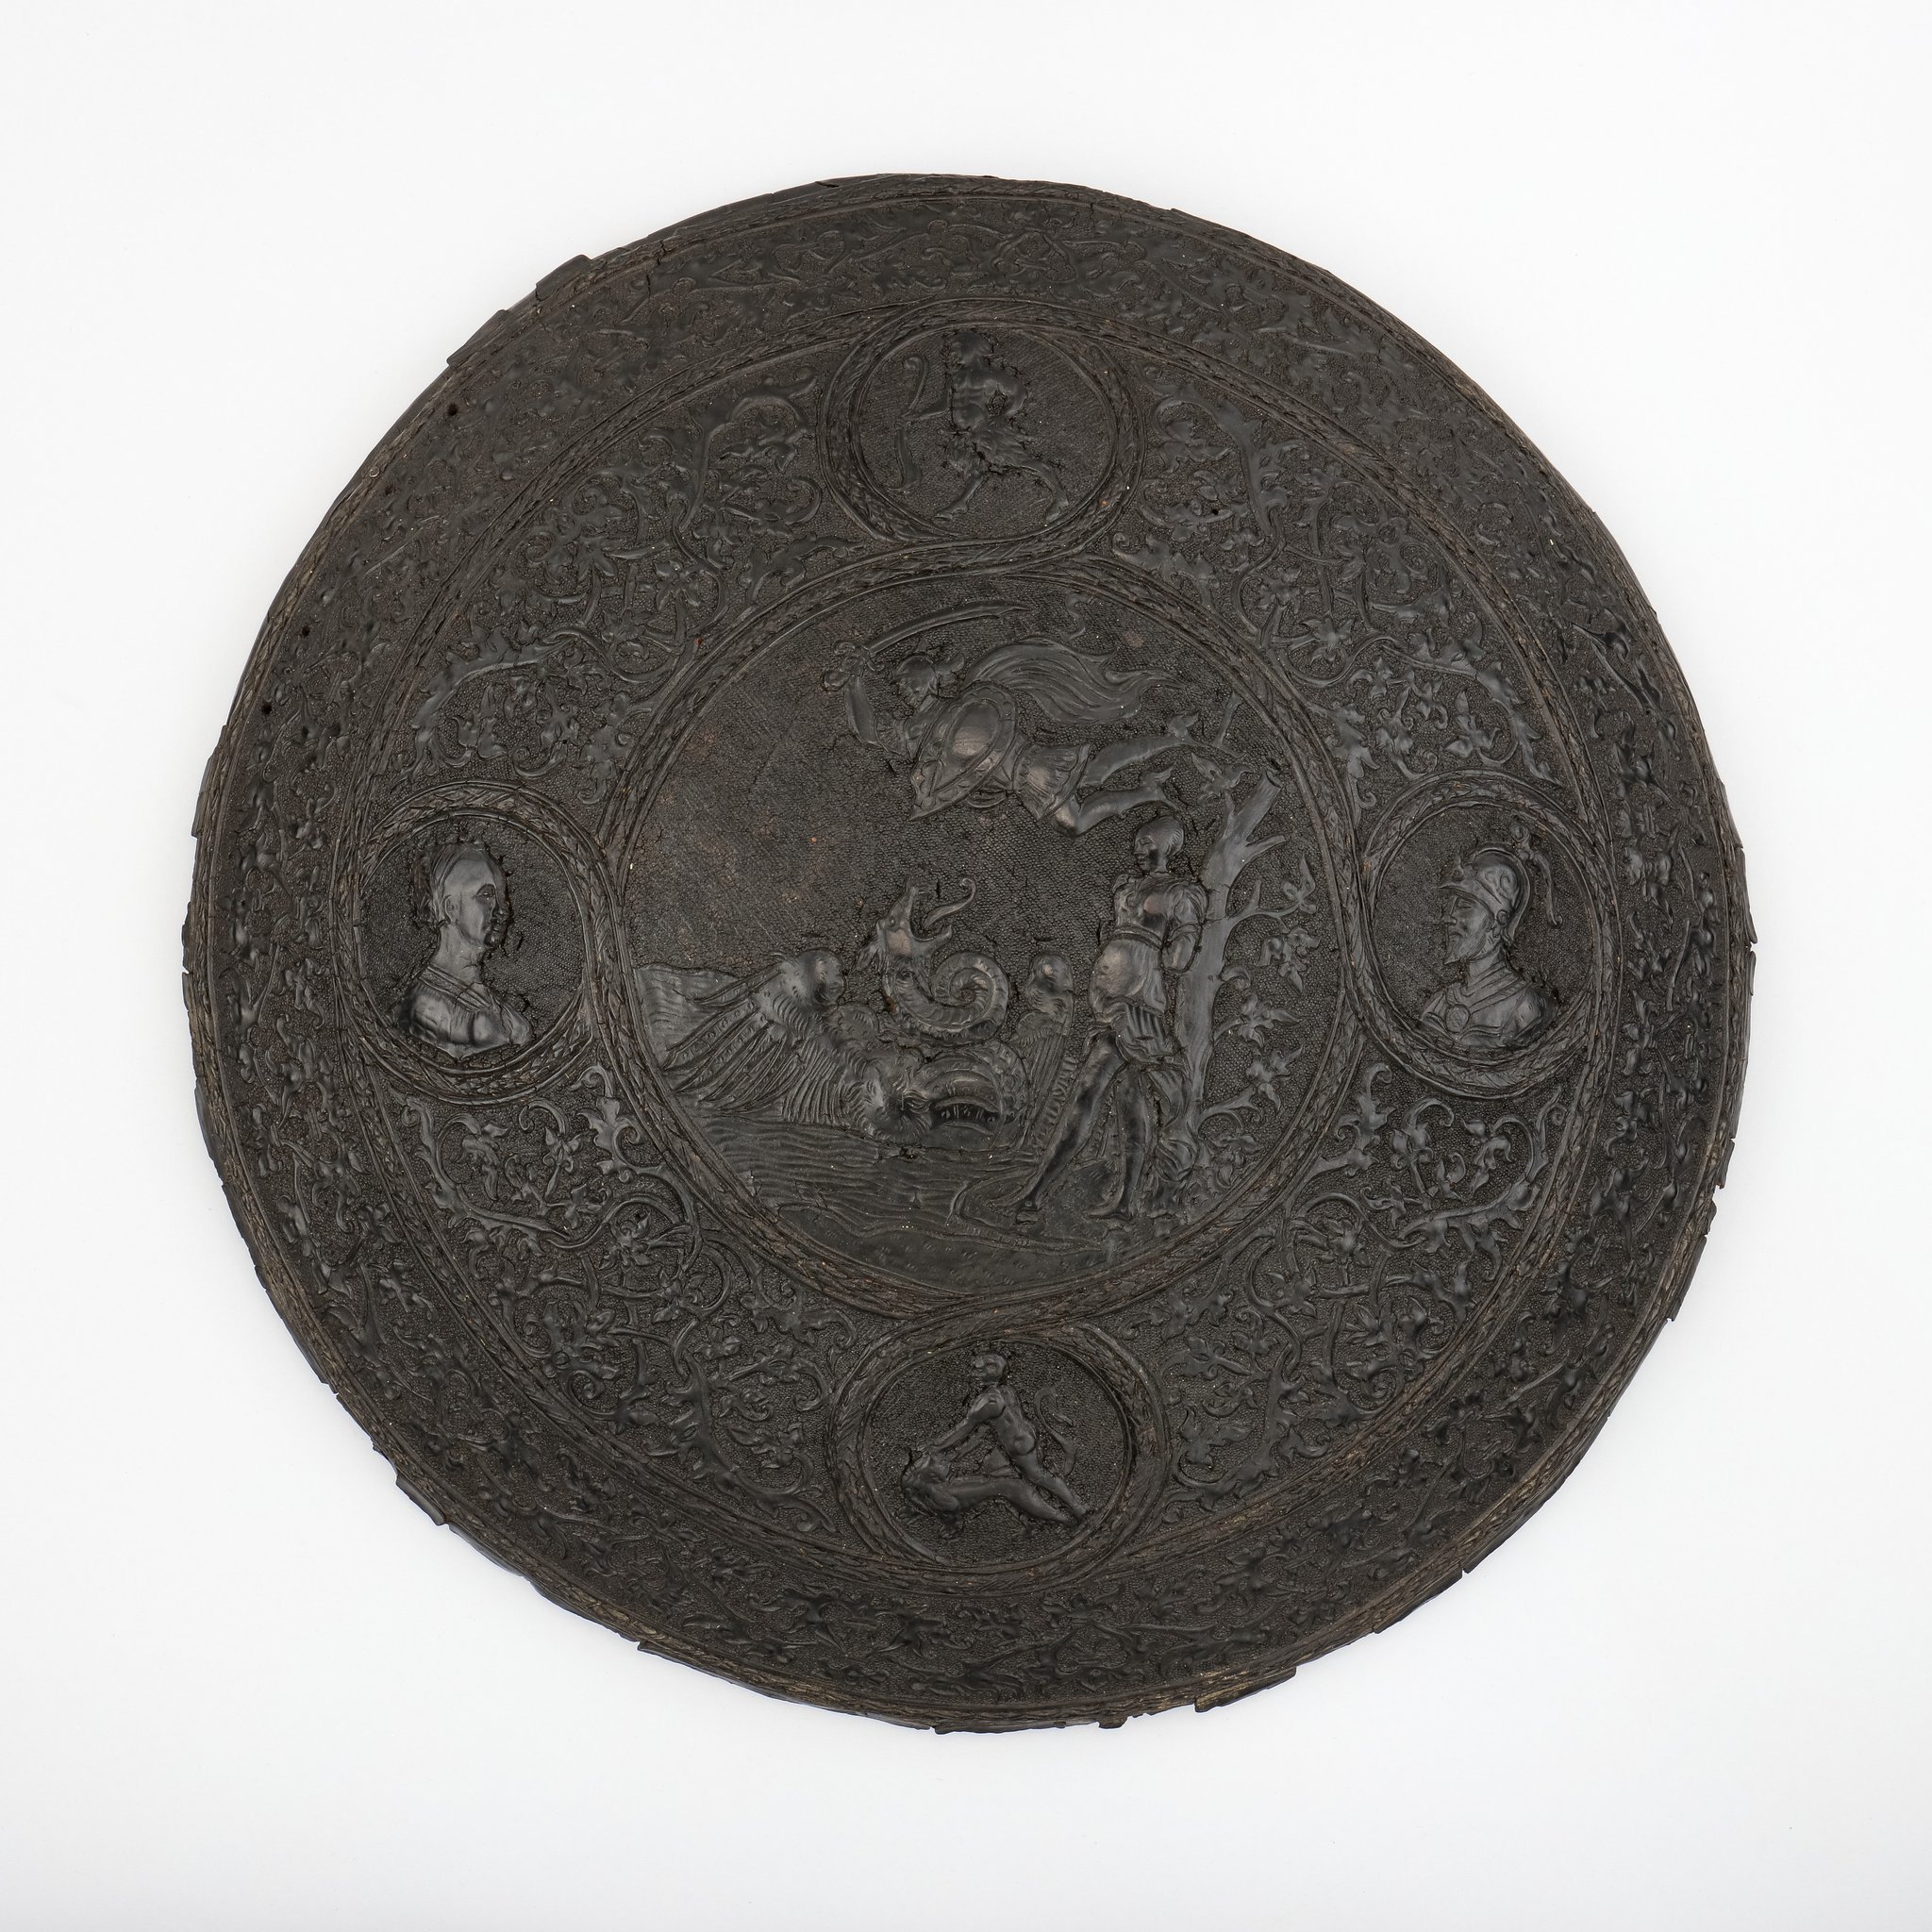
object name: embossed shield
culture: italian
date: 1560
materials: leather, wood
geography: italy